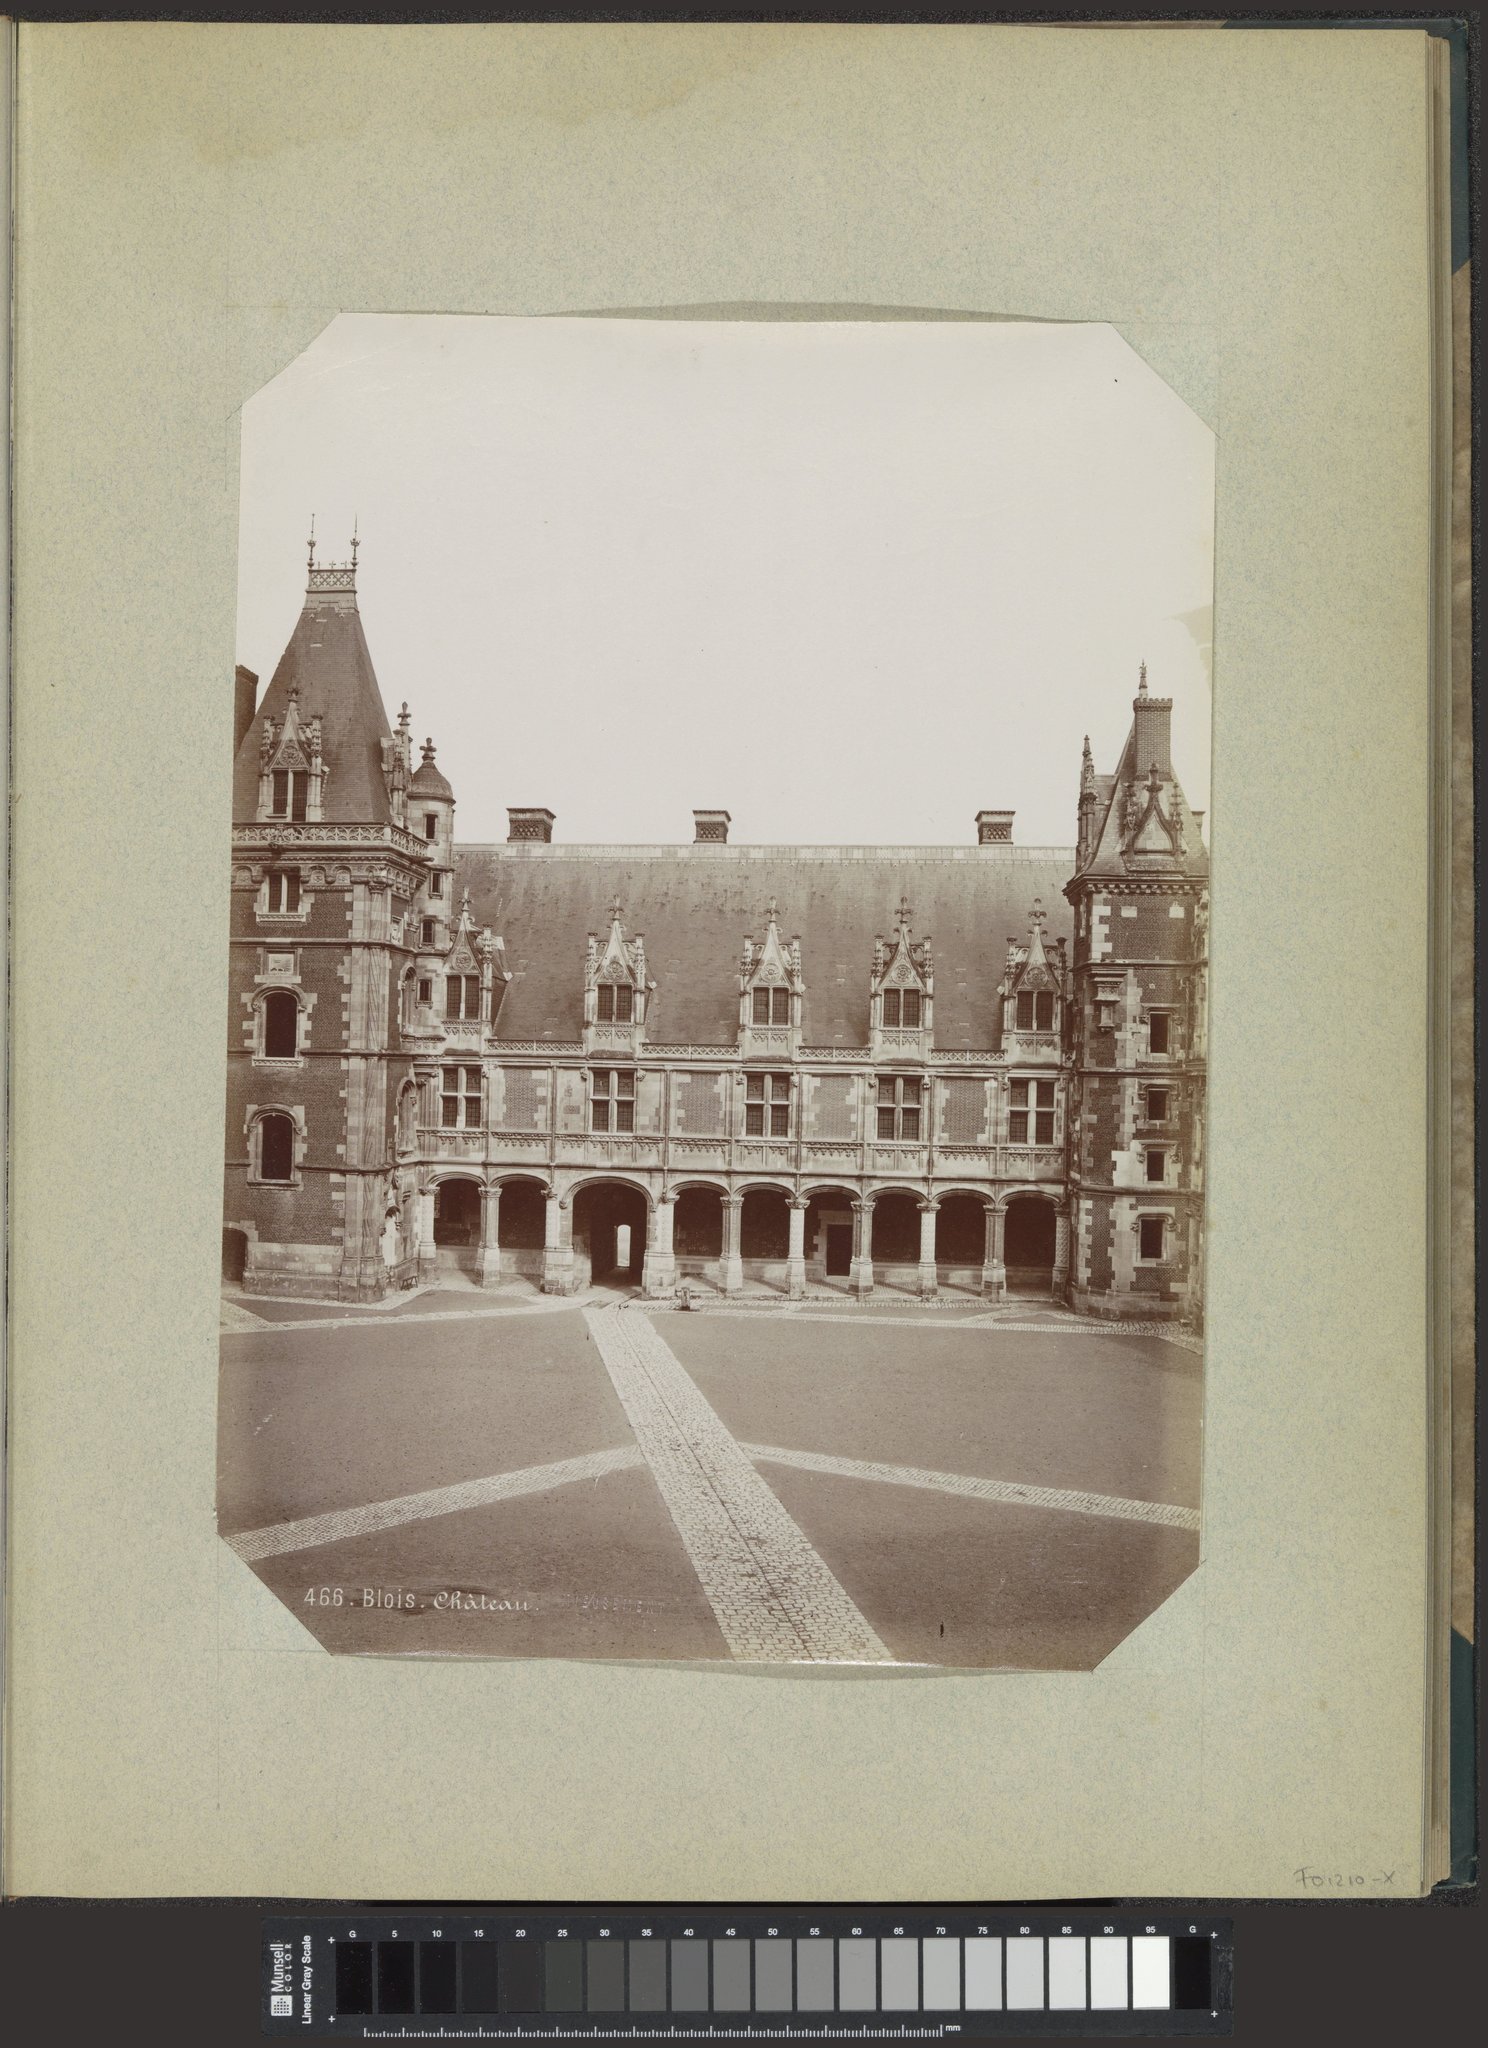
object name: photograph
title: Blois. Château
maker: séraphin-médéric mieusement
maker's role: fotograaf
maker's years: 1840-1905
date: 1880-1900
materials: photographic support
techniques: albumen print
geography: blois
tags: castle, courtyard, façade (of house or building)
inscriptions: inscription: ‘Monuments Historiques’, name: ‘Mieusement photographe’, number: ‘466’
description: Onderdeel van Fotoalbum met opnames van monumenten in Frankrijk.